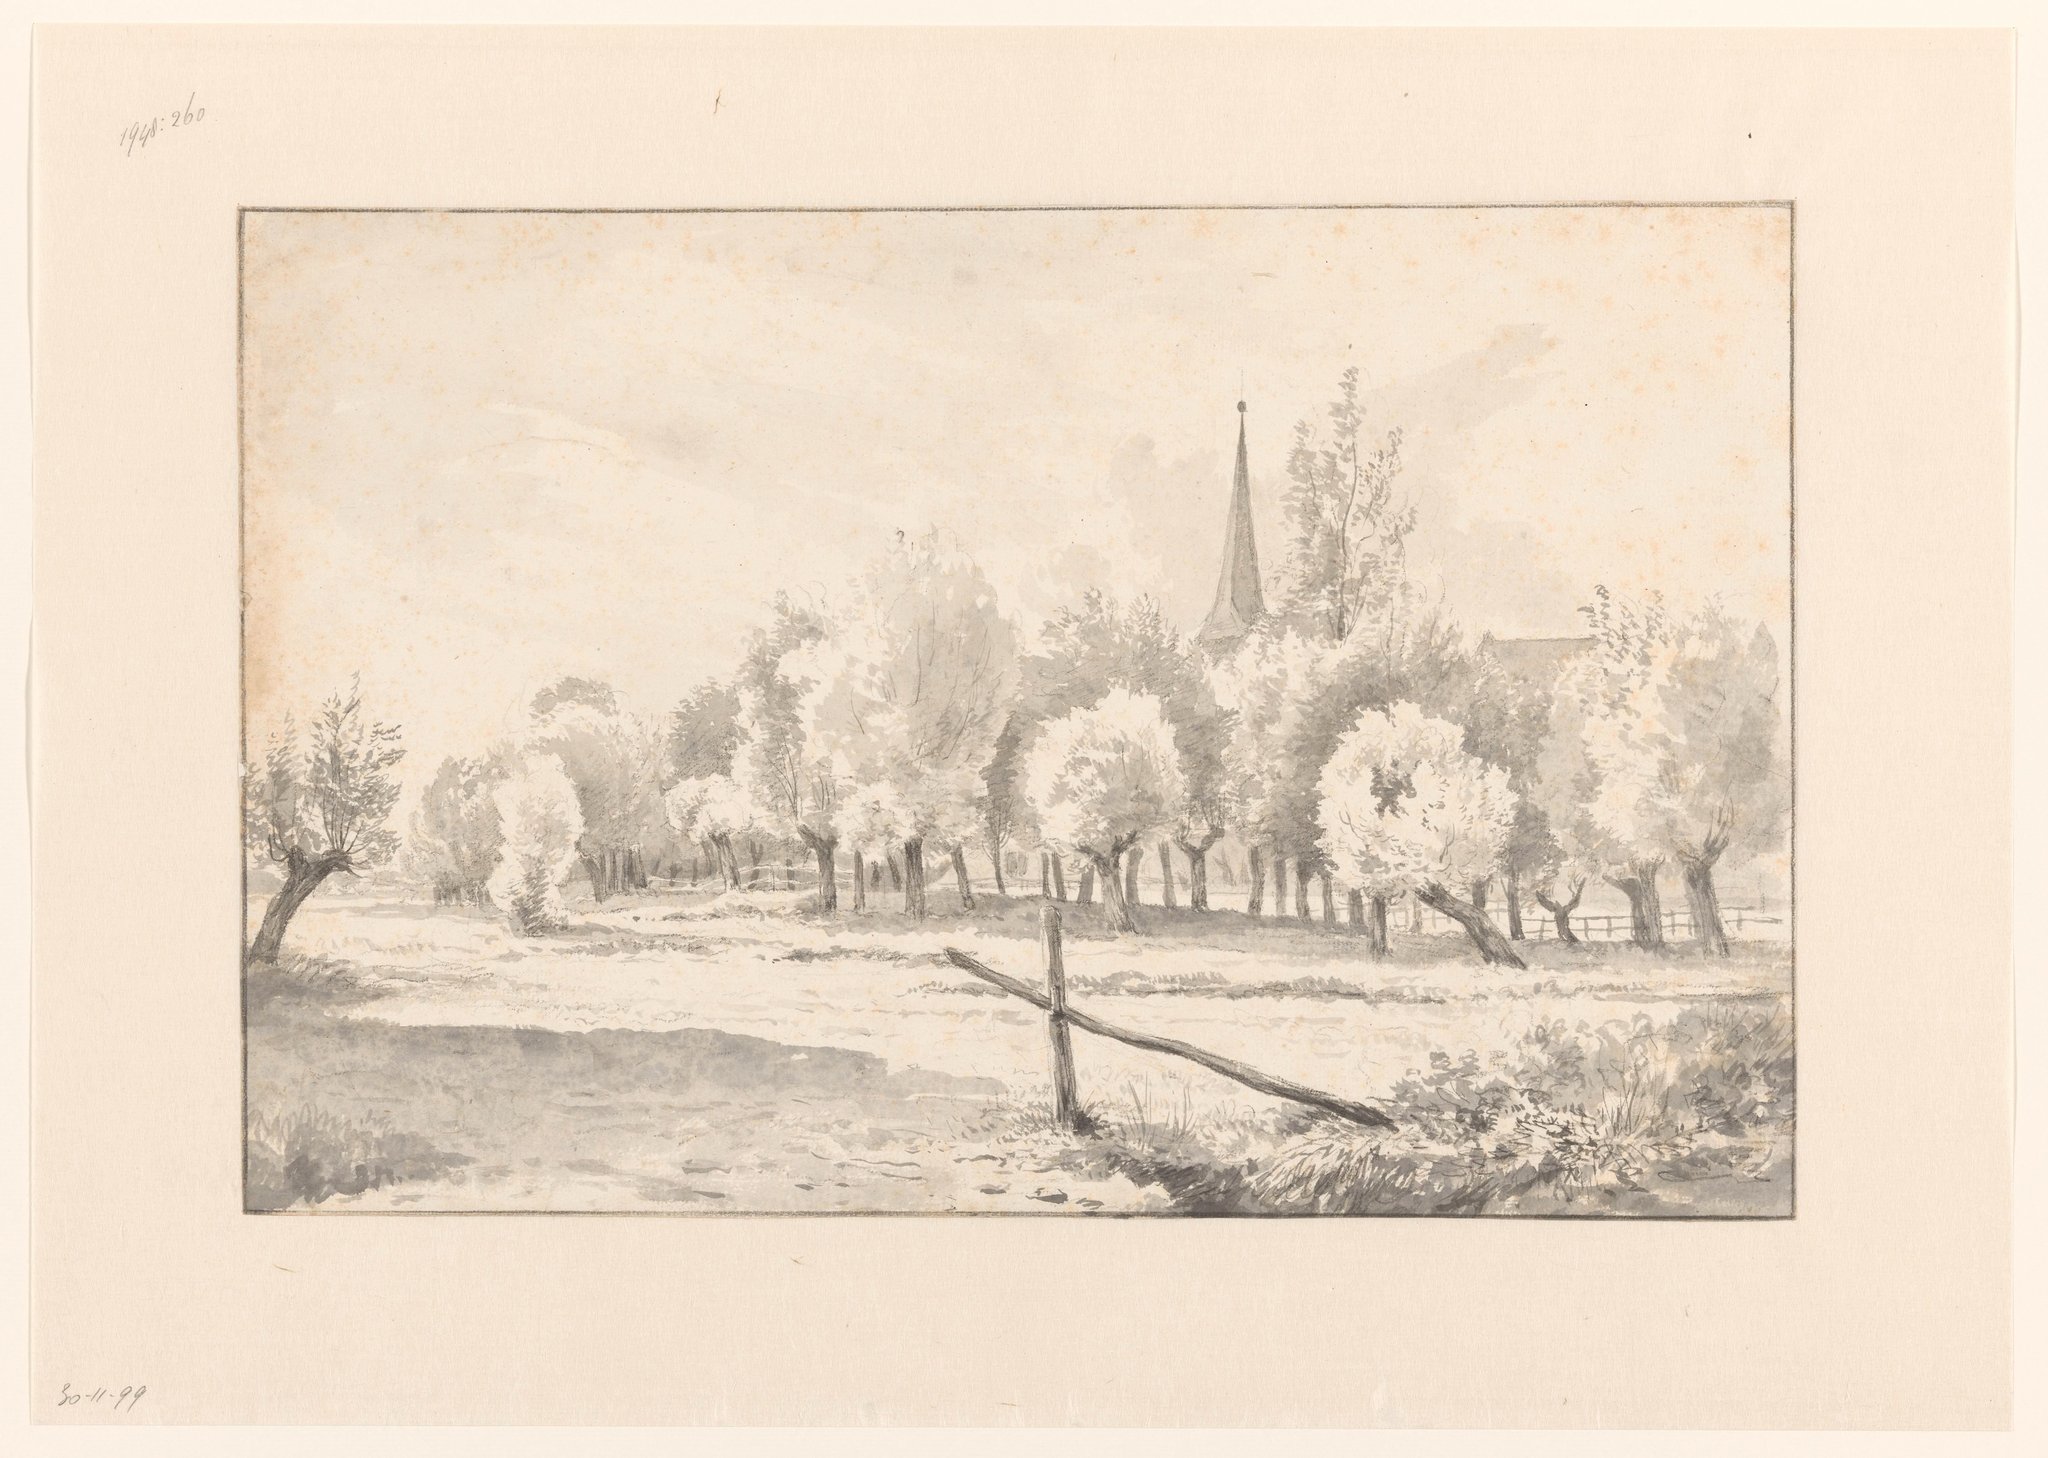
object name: drawing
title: Weiland met knotwilgen en op de achtergrond een kerktoren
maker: cornelis steffelaar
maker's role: draughtsman, painter, print maker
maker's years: 1797-1861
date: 1807-1861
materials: chalk, paper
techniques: brush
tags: trees: pollard willow, meadow, pasture, landscape with tower or castle